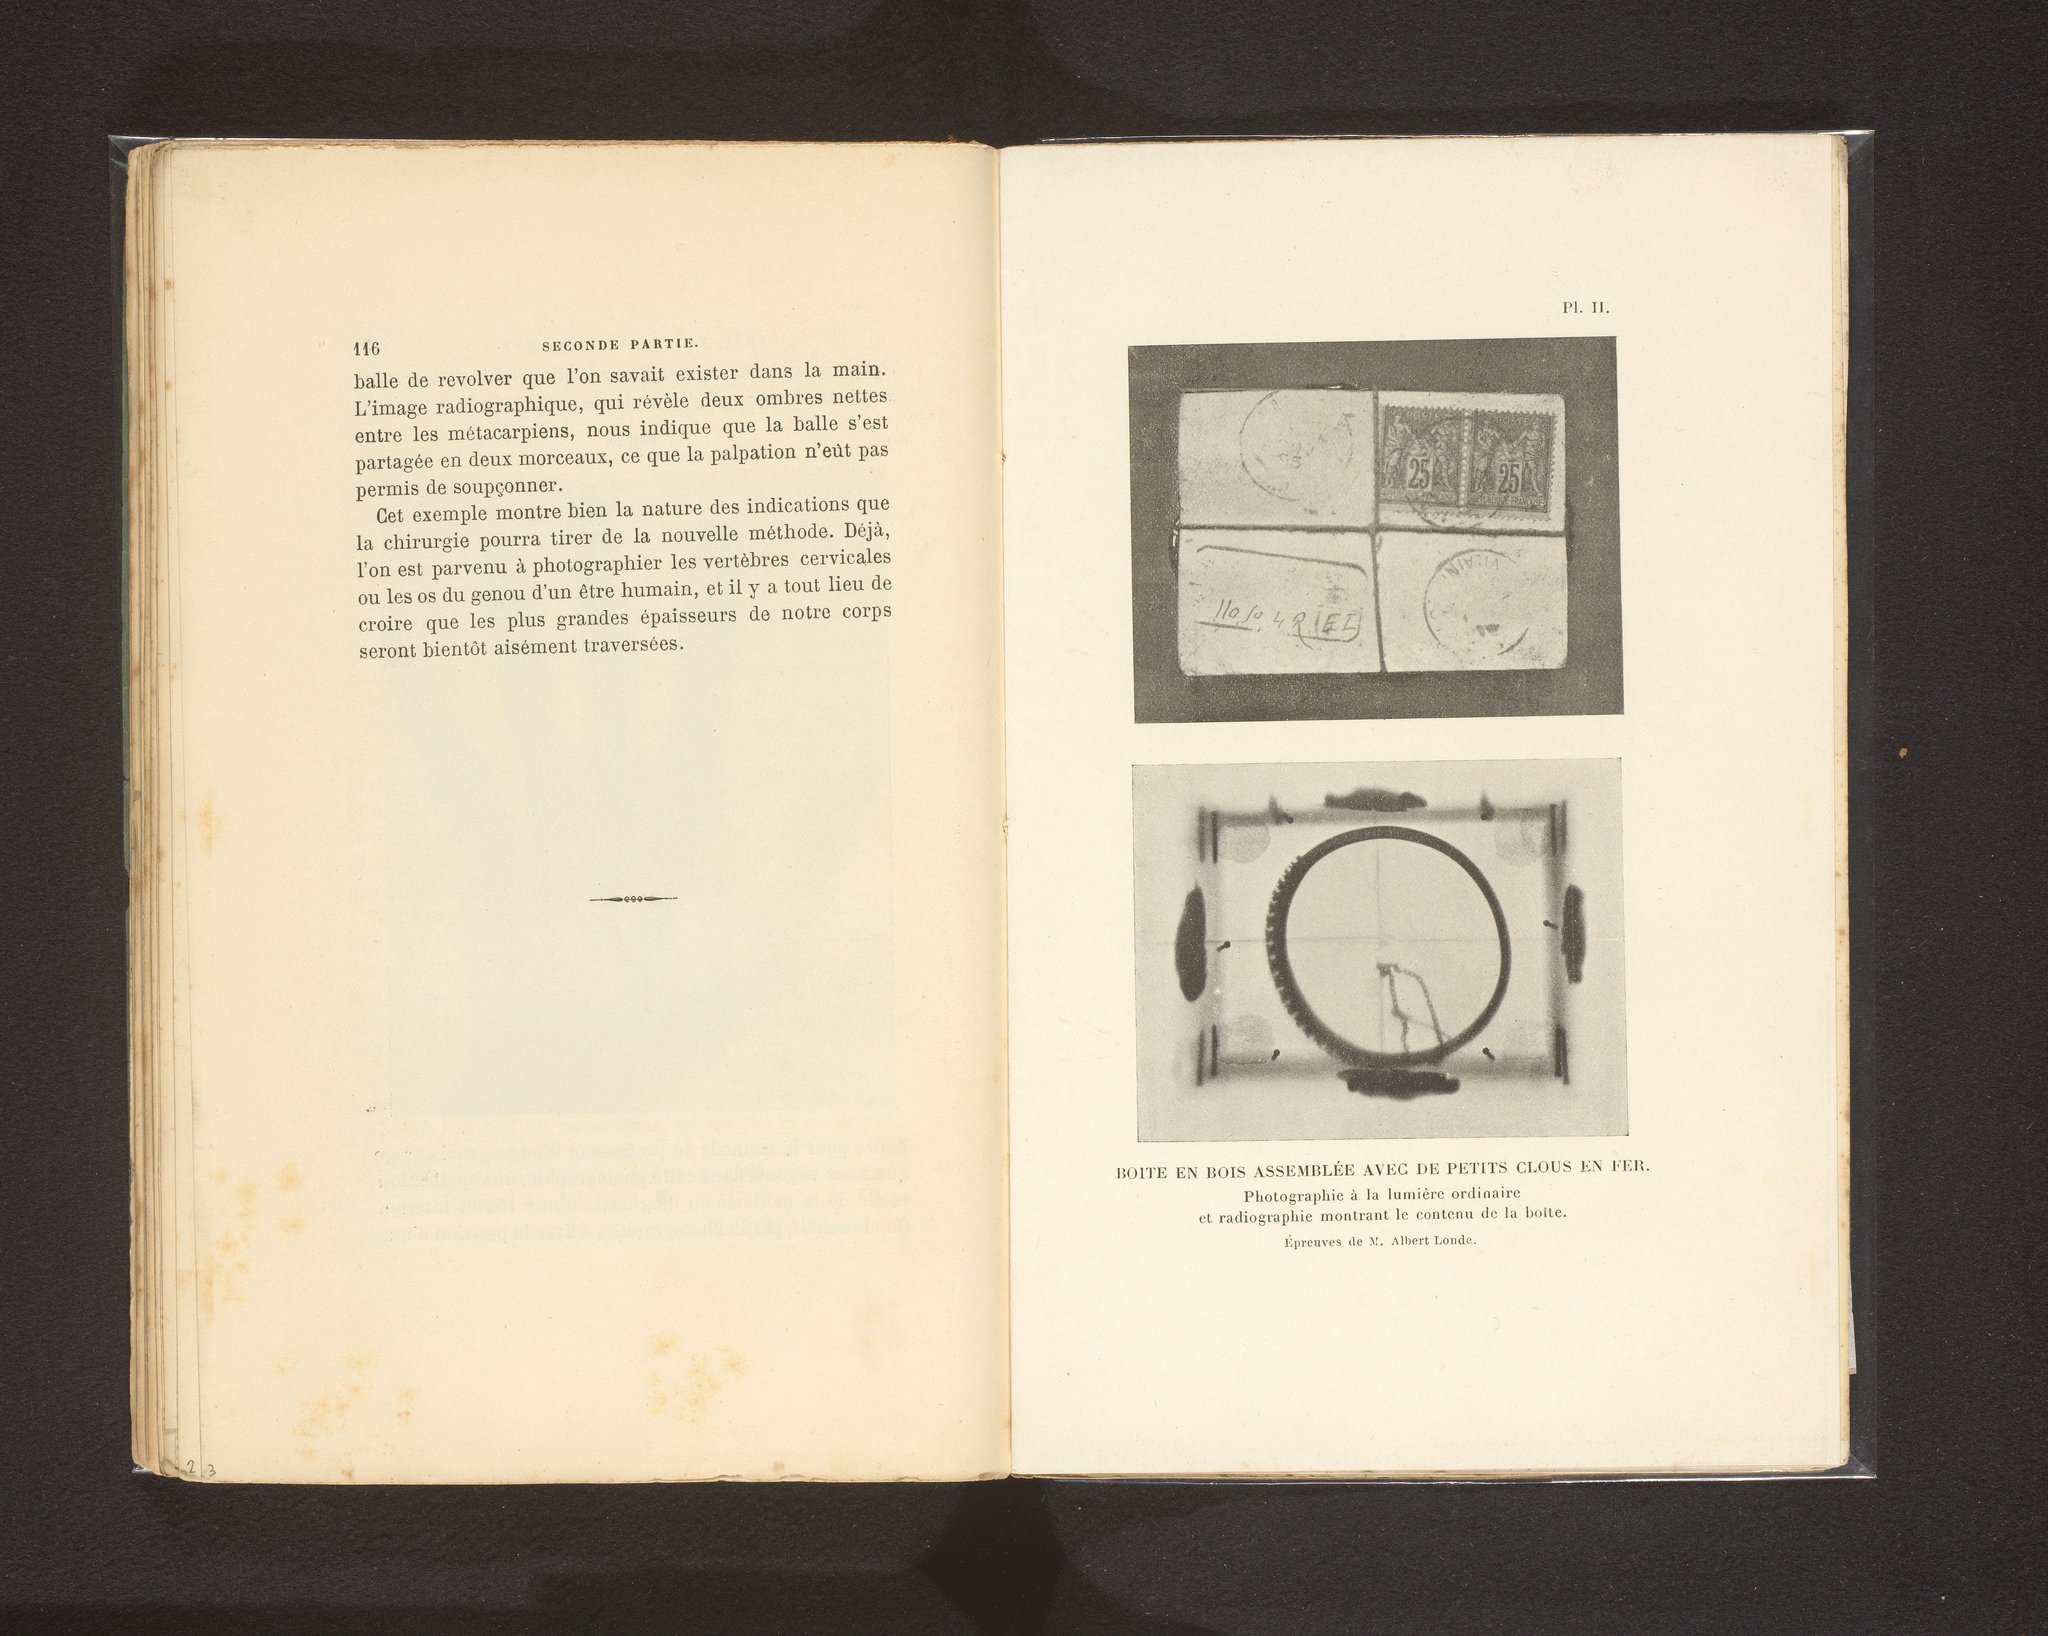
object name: page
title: Boite en bois assemblée avec de petits clous en fer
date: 1886-1896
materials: paper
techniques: autotype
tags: x-ray examination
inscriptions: number: ‘Pl. II.’, inscription: ‘Photographie à la lumière ordinaire et radiographie montrant le contenu de la boîte.’